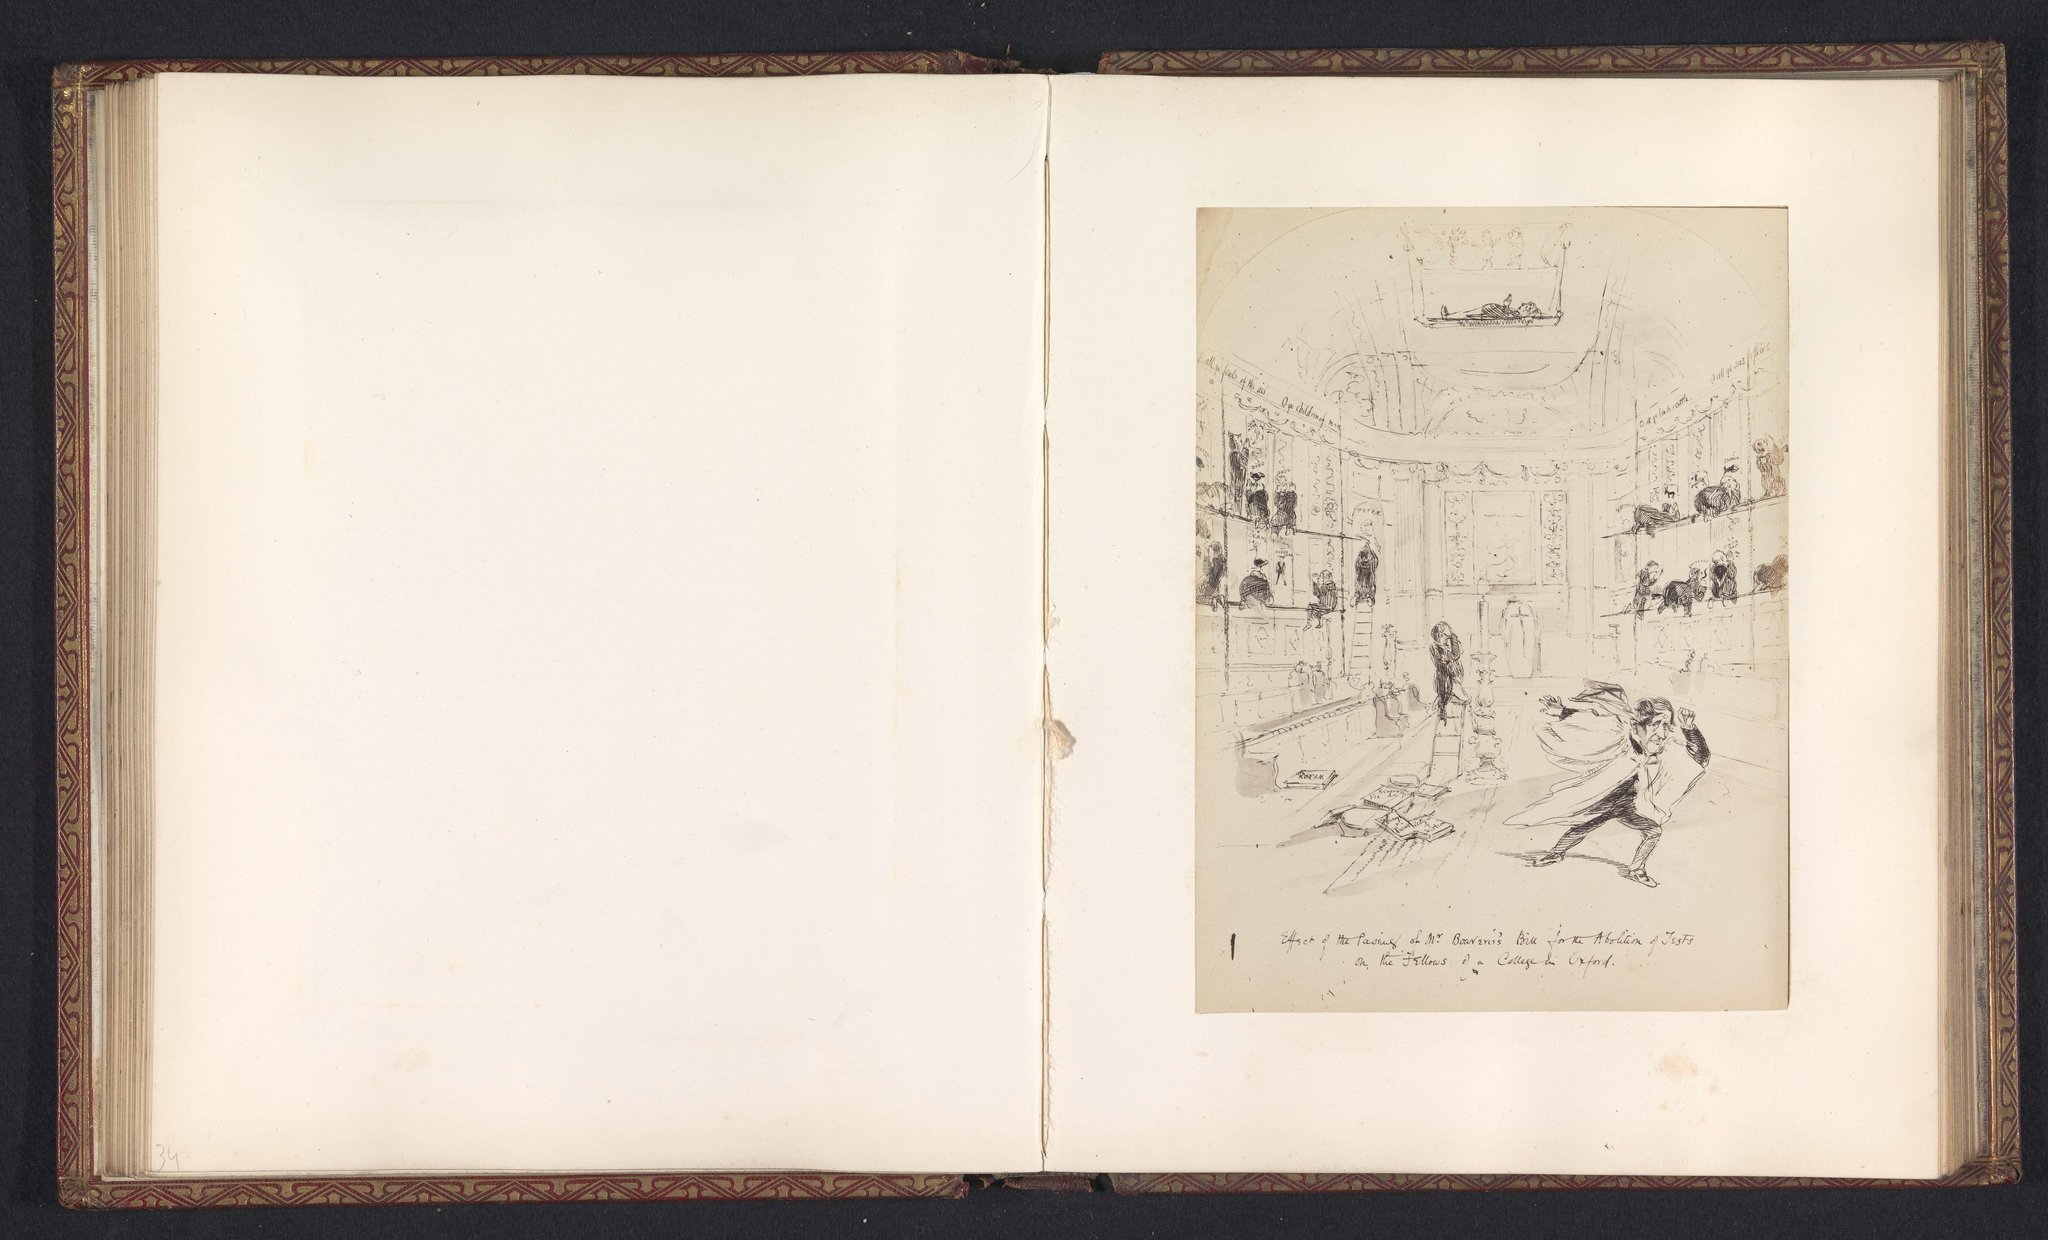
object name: page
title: Fotoreproductie van een tekening, voorstellende studenten aanbidden schilderingen in de Worcester College Chapel te Oxford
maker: Anonymous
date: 1855-1866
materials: photographic support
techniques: albumen print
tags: caricatures (human types), student life, parts of church interior: chapel